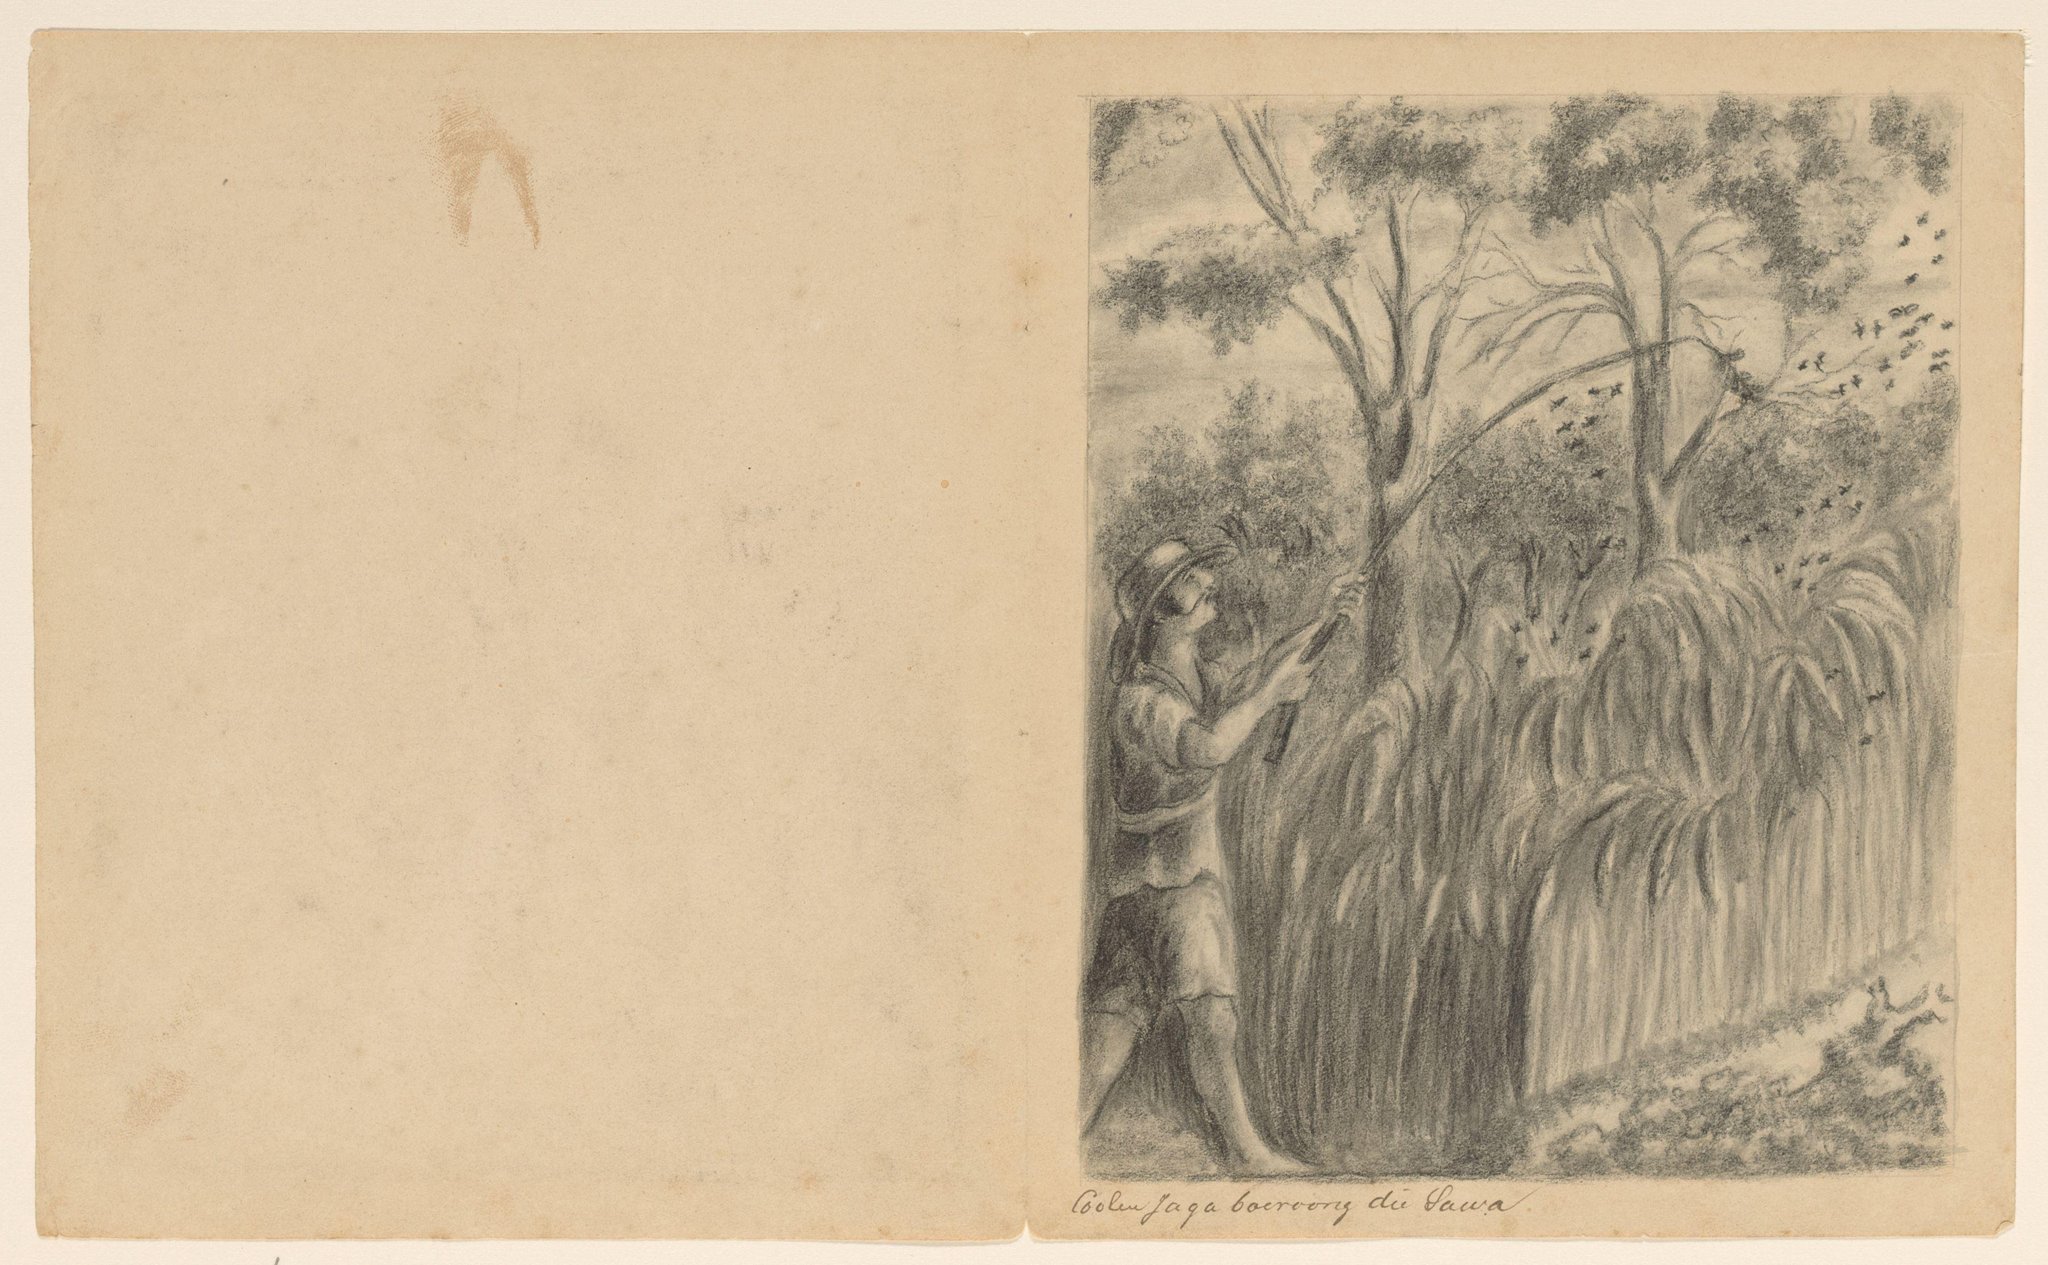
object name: drawing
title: Coolen verjaagt vogels uit de rijstvelden, ca. 1820-1850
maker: Anonymous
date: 1850-1950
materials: chalk, paper, pencil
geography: indonesia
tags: coenraad laurens coolen, oost-java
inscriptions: collector's mark: Lugt 2228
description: Coolen verjaagt vogels uit de rijstvelden. Onderdeel van een groep van twaalf losse bladen uit een schetsboek met tekeningen over het leven van Coenraad Laurens Coolen, evangelist op Oost-Java, ca. 1820-1850. Elk blad heeft een tekening op de rechterhelft, met een onderschrift in het Indonesisch.